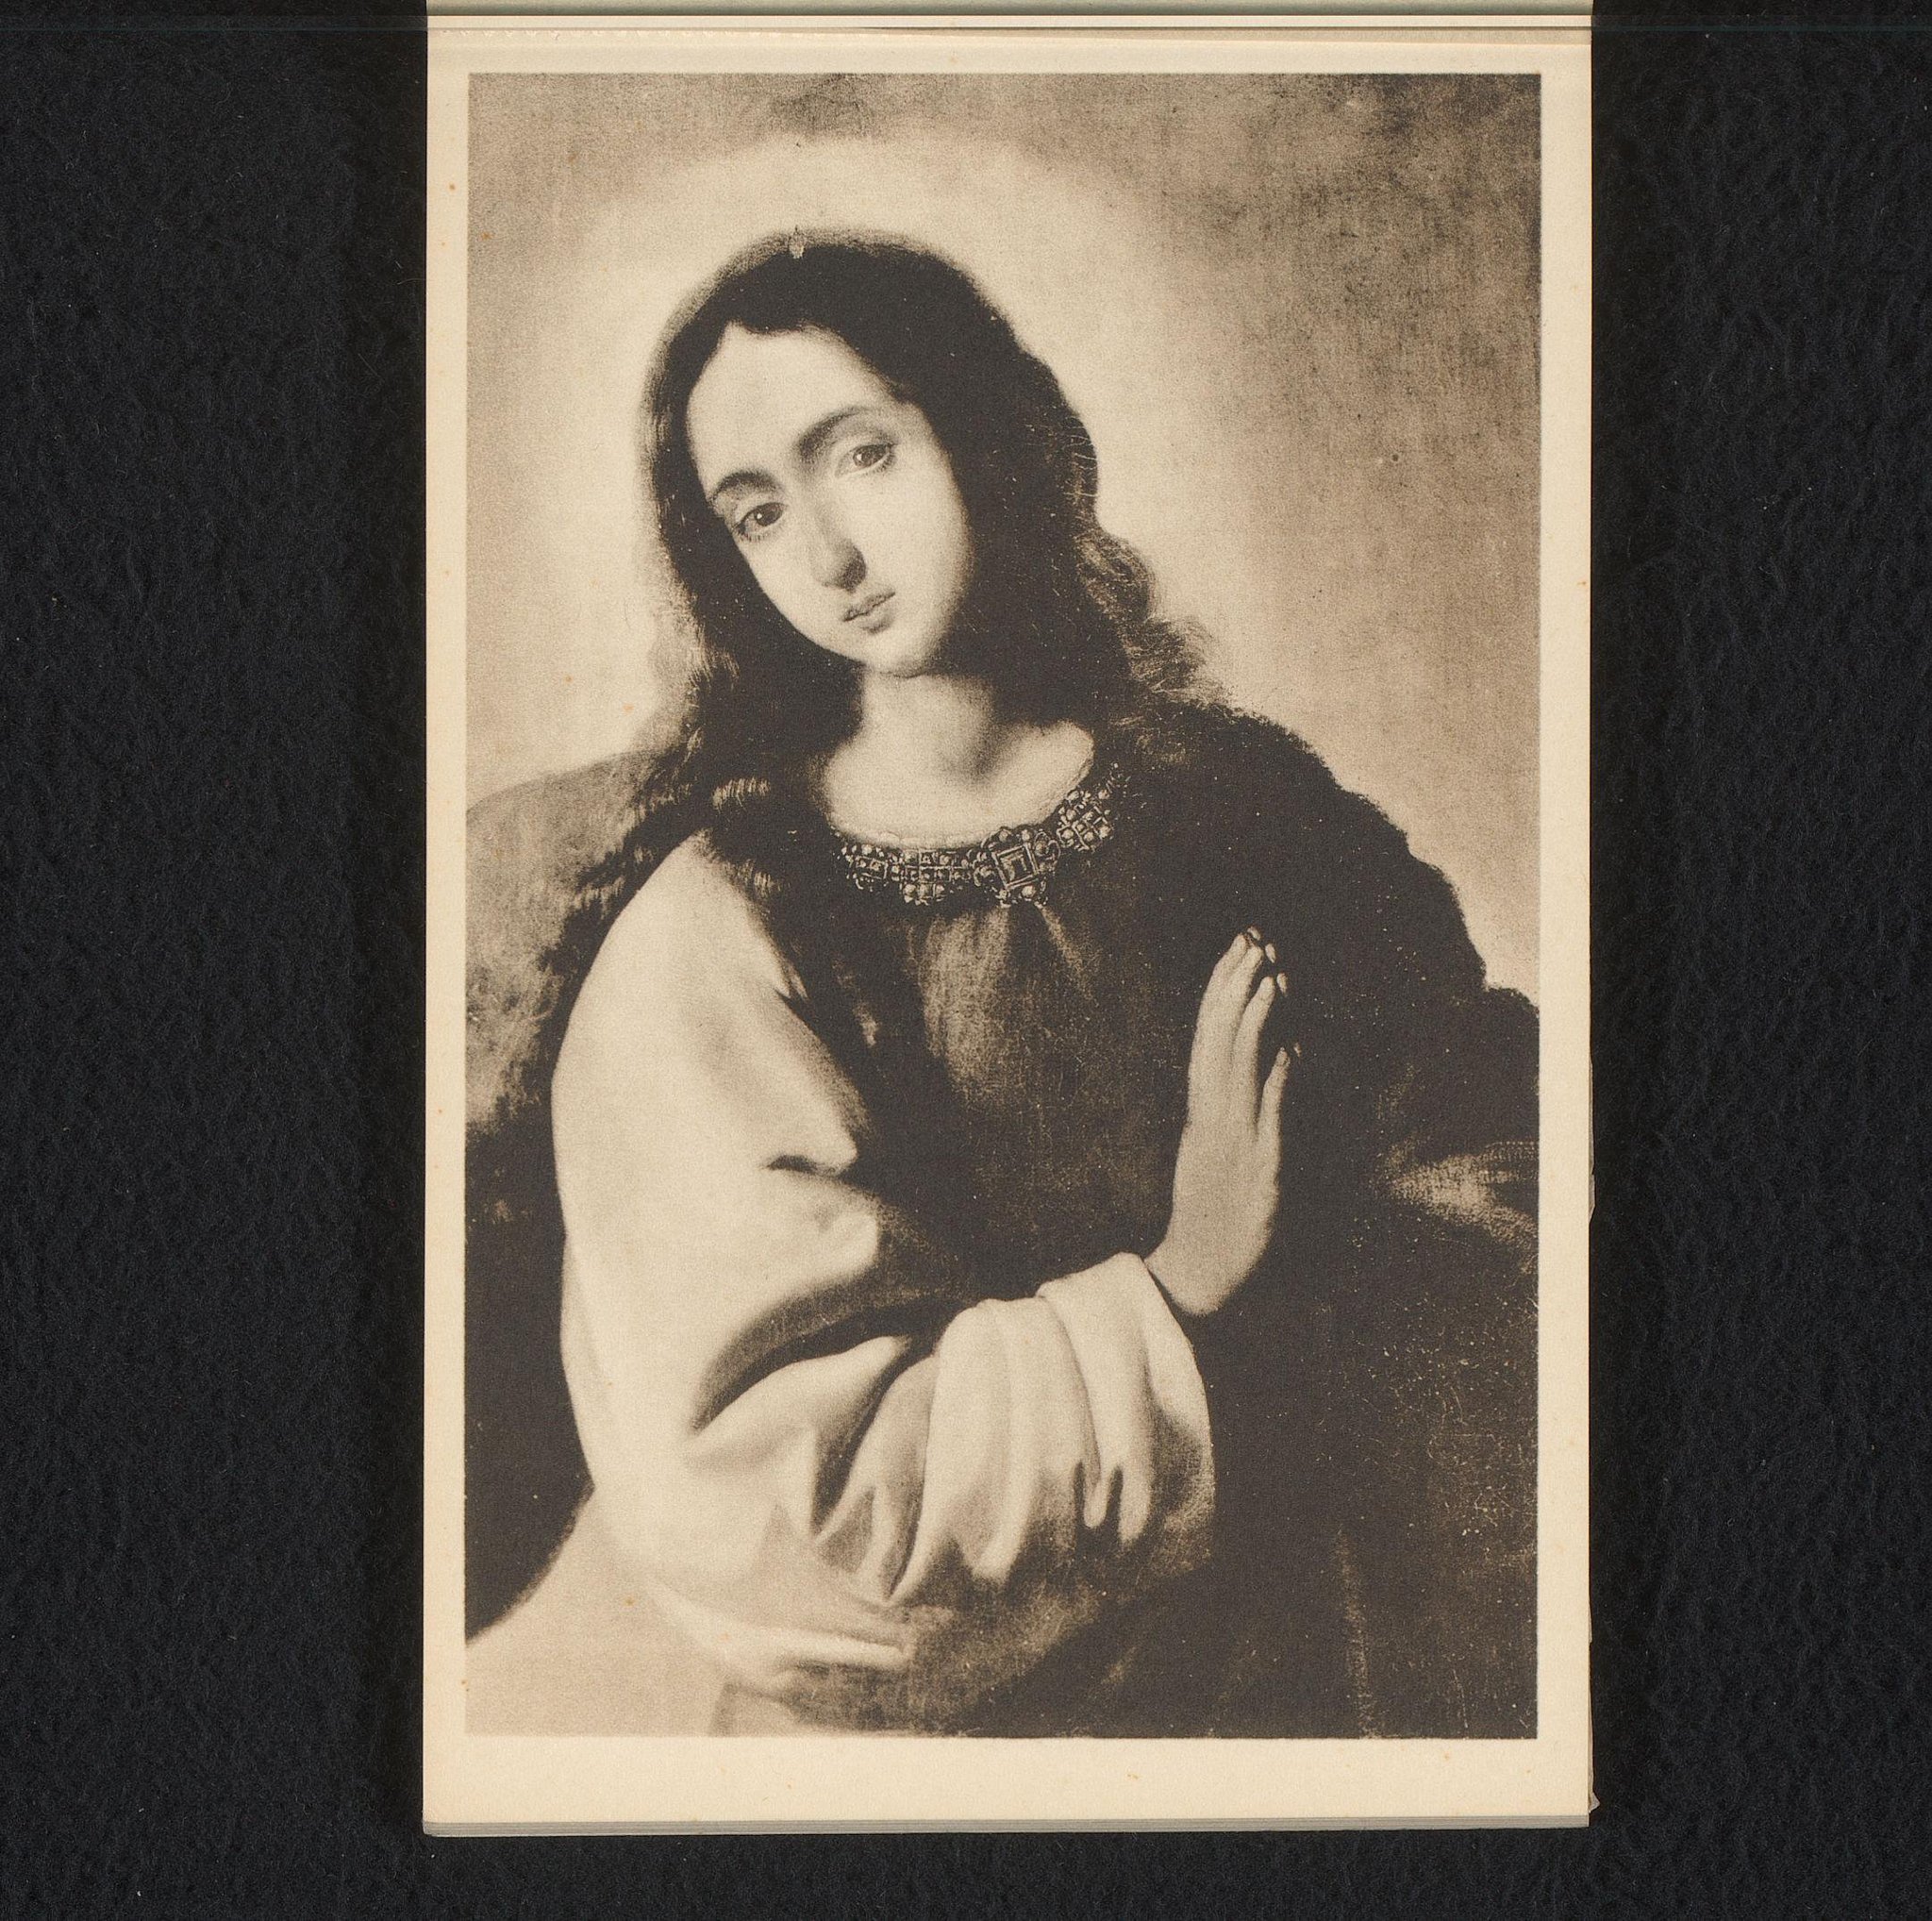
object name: ansichtkaart, prentbriefkaart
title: Museo Cerralbo. Madrid. La Purisima Concepción. Detalle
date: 1924-1930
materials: cardboard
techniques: photograph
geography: madrid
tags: permanent exhibition, museum, picture, painting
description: Prentbriefkaart maakt deel uit van een album.